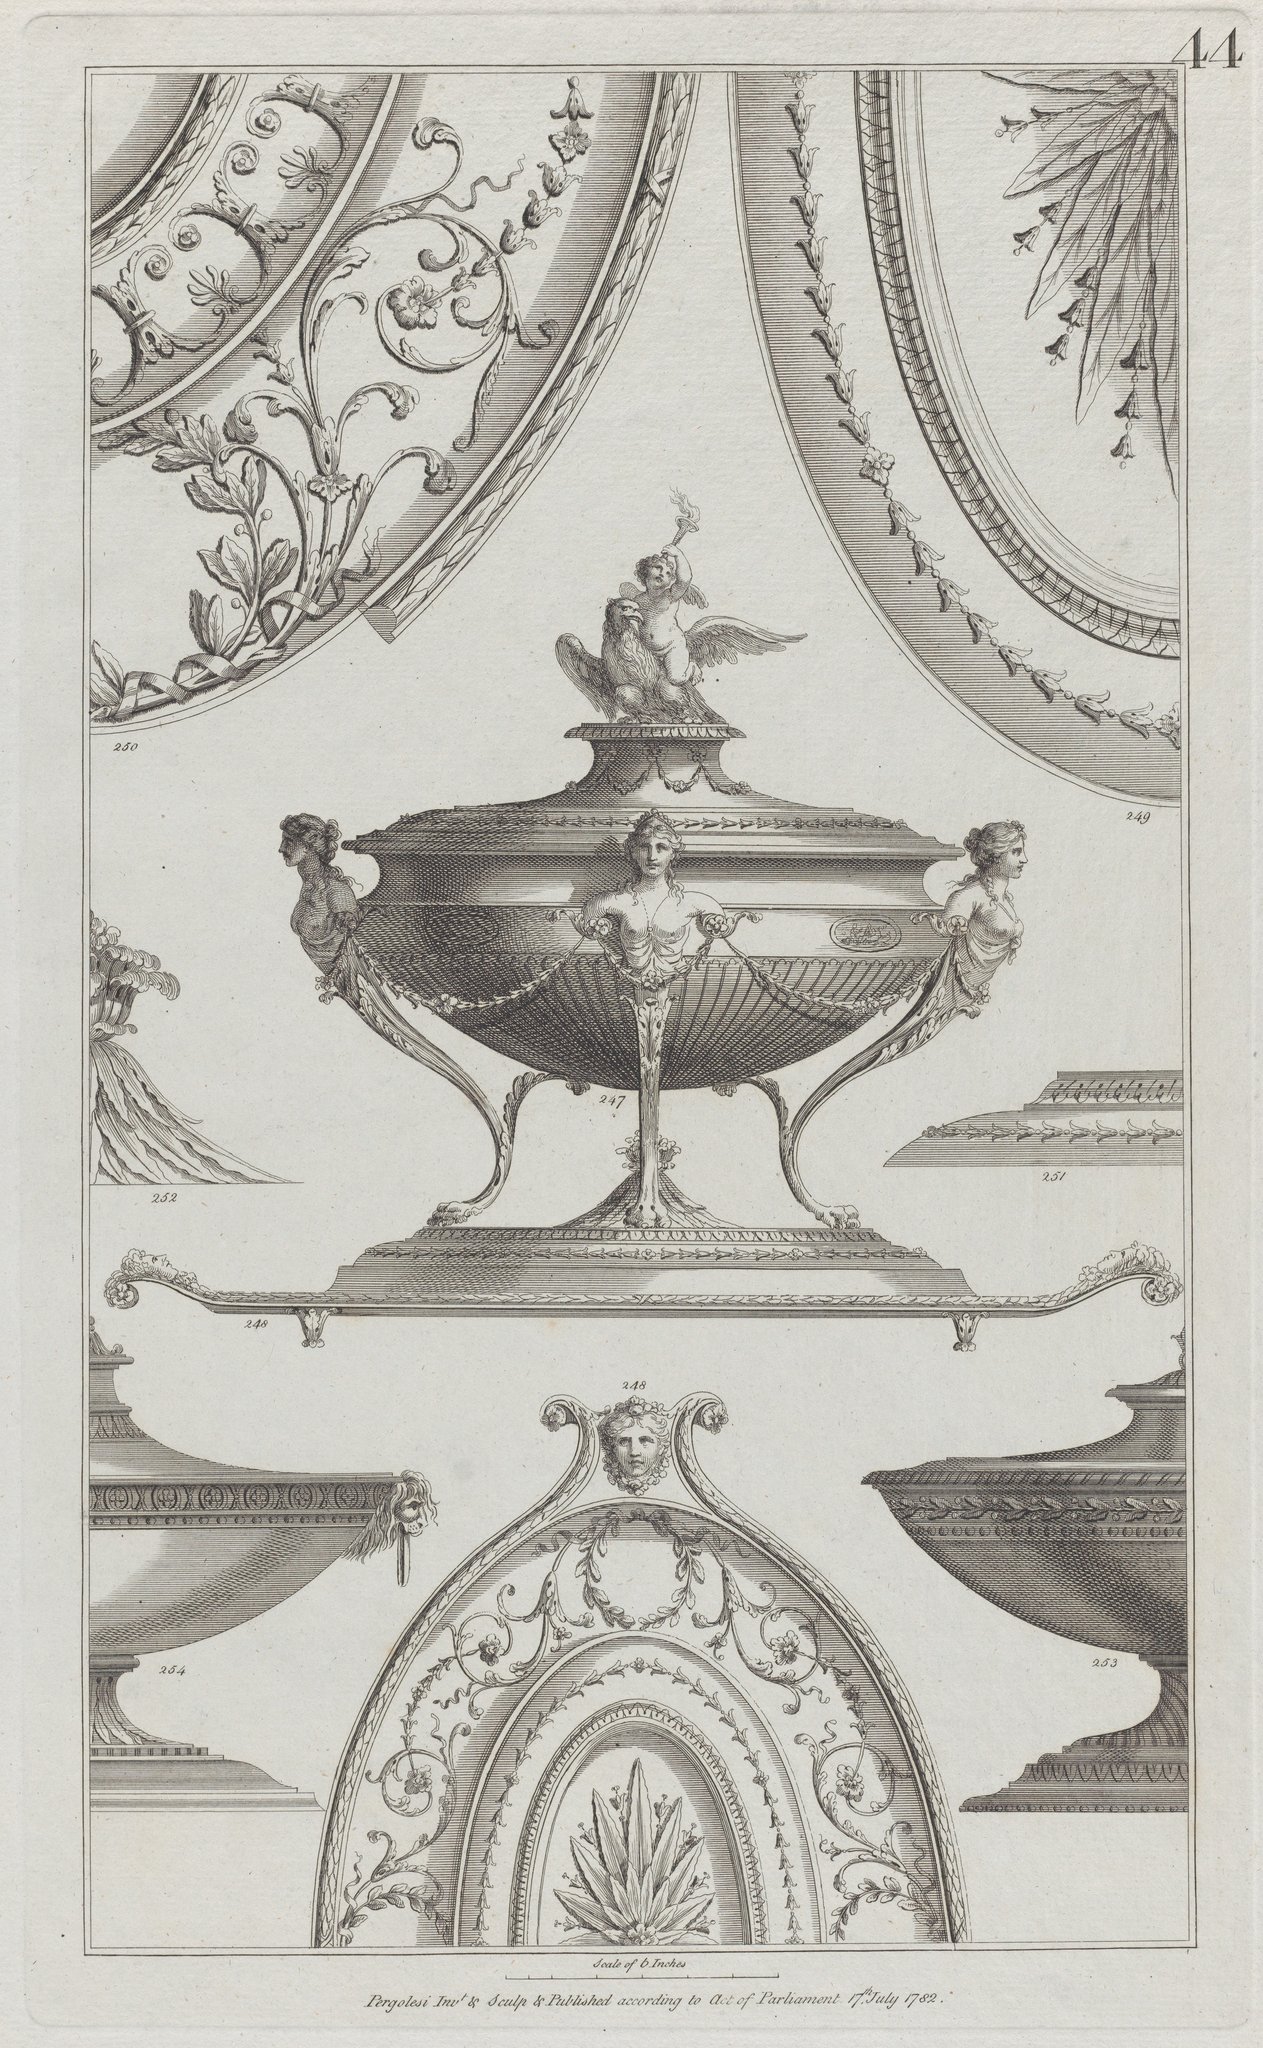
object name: print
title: Vases and Vessels, nos. 248–254, plate 44 from "Designs for Various Ornaments"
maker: michelangelo pergolesi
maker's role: artist and publisher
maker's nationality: italian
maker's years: 1760-1801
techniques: engraving, etching